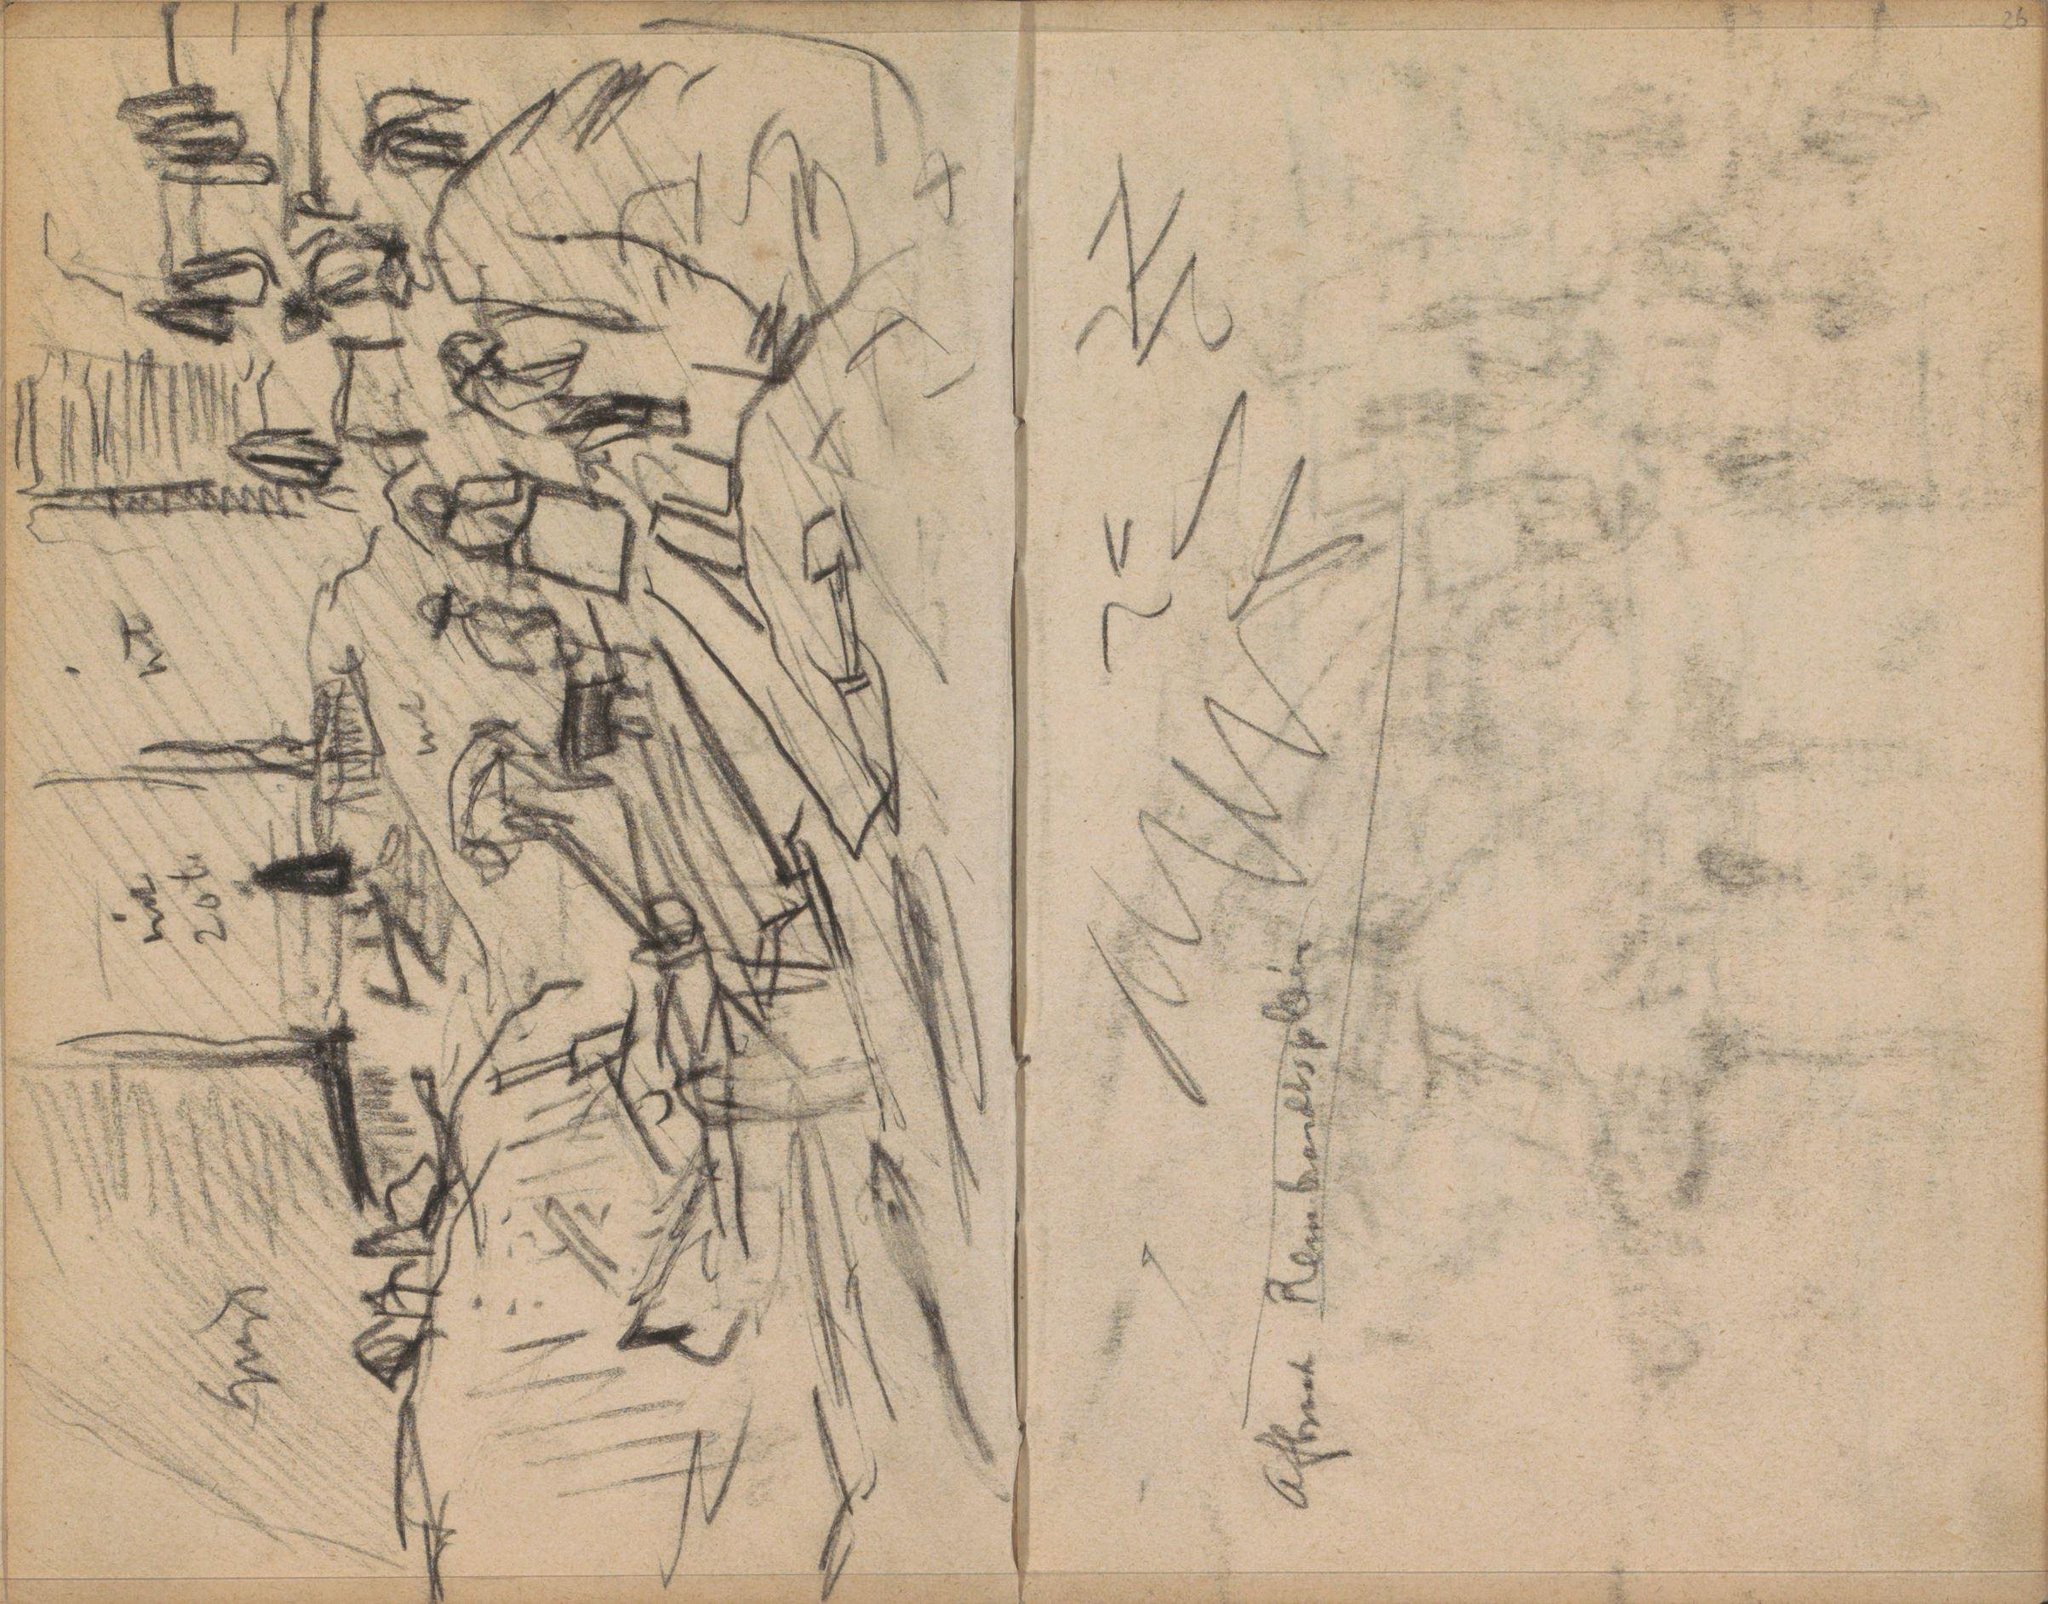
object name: sketchbook leaf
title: Afbraak van het Rembrandtplein te Amsterdam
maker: george hendrik breitner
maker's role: draughtsman, painter, print maker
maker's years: 1857-1923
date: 1902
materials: chalk, paper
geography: amsterdam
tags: demolition of building (+ men (labourers)), civic architecture; edifices; dwellings, square, place, circus, etc. (+ city(-scape) with figures, staffage)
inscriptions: annotation: ‘Afbraak Rembrandtsplein’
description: Arbeiders aan het werk. Pagina 25 en pagina 26 uit een schetsboek met 46 bladen vervaardigd in de omgeving van Amsterdam, Rotterdam en Haarlem.